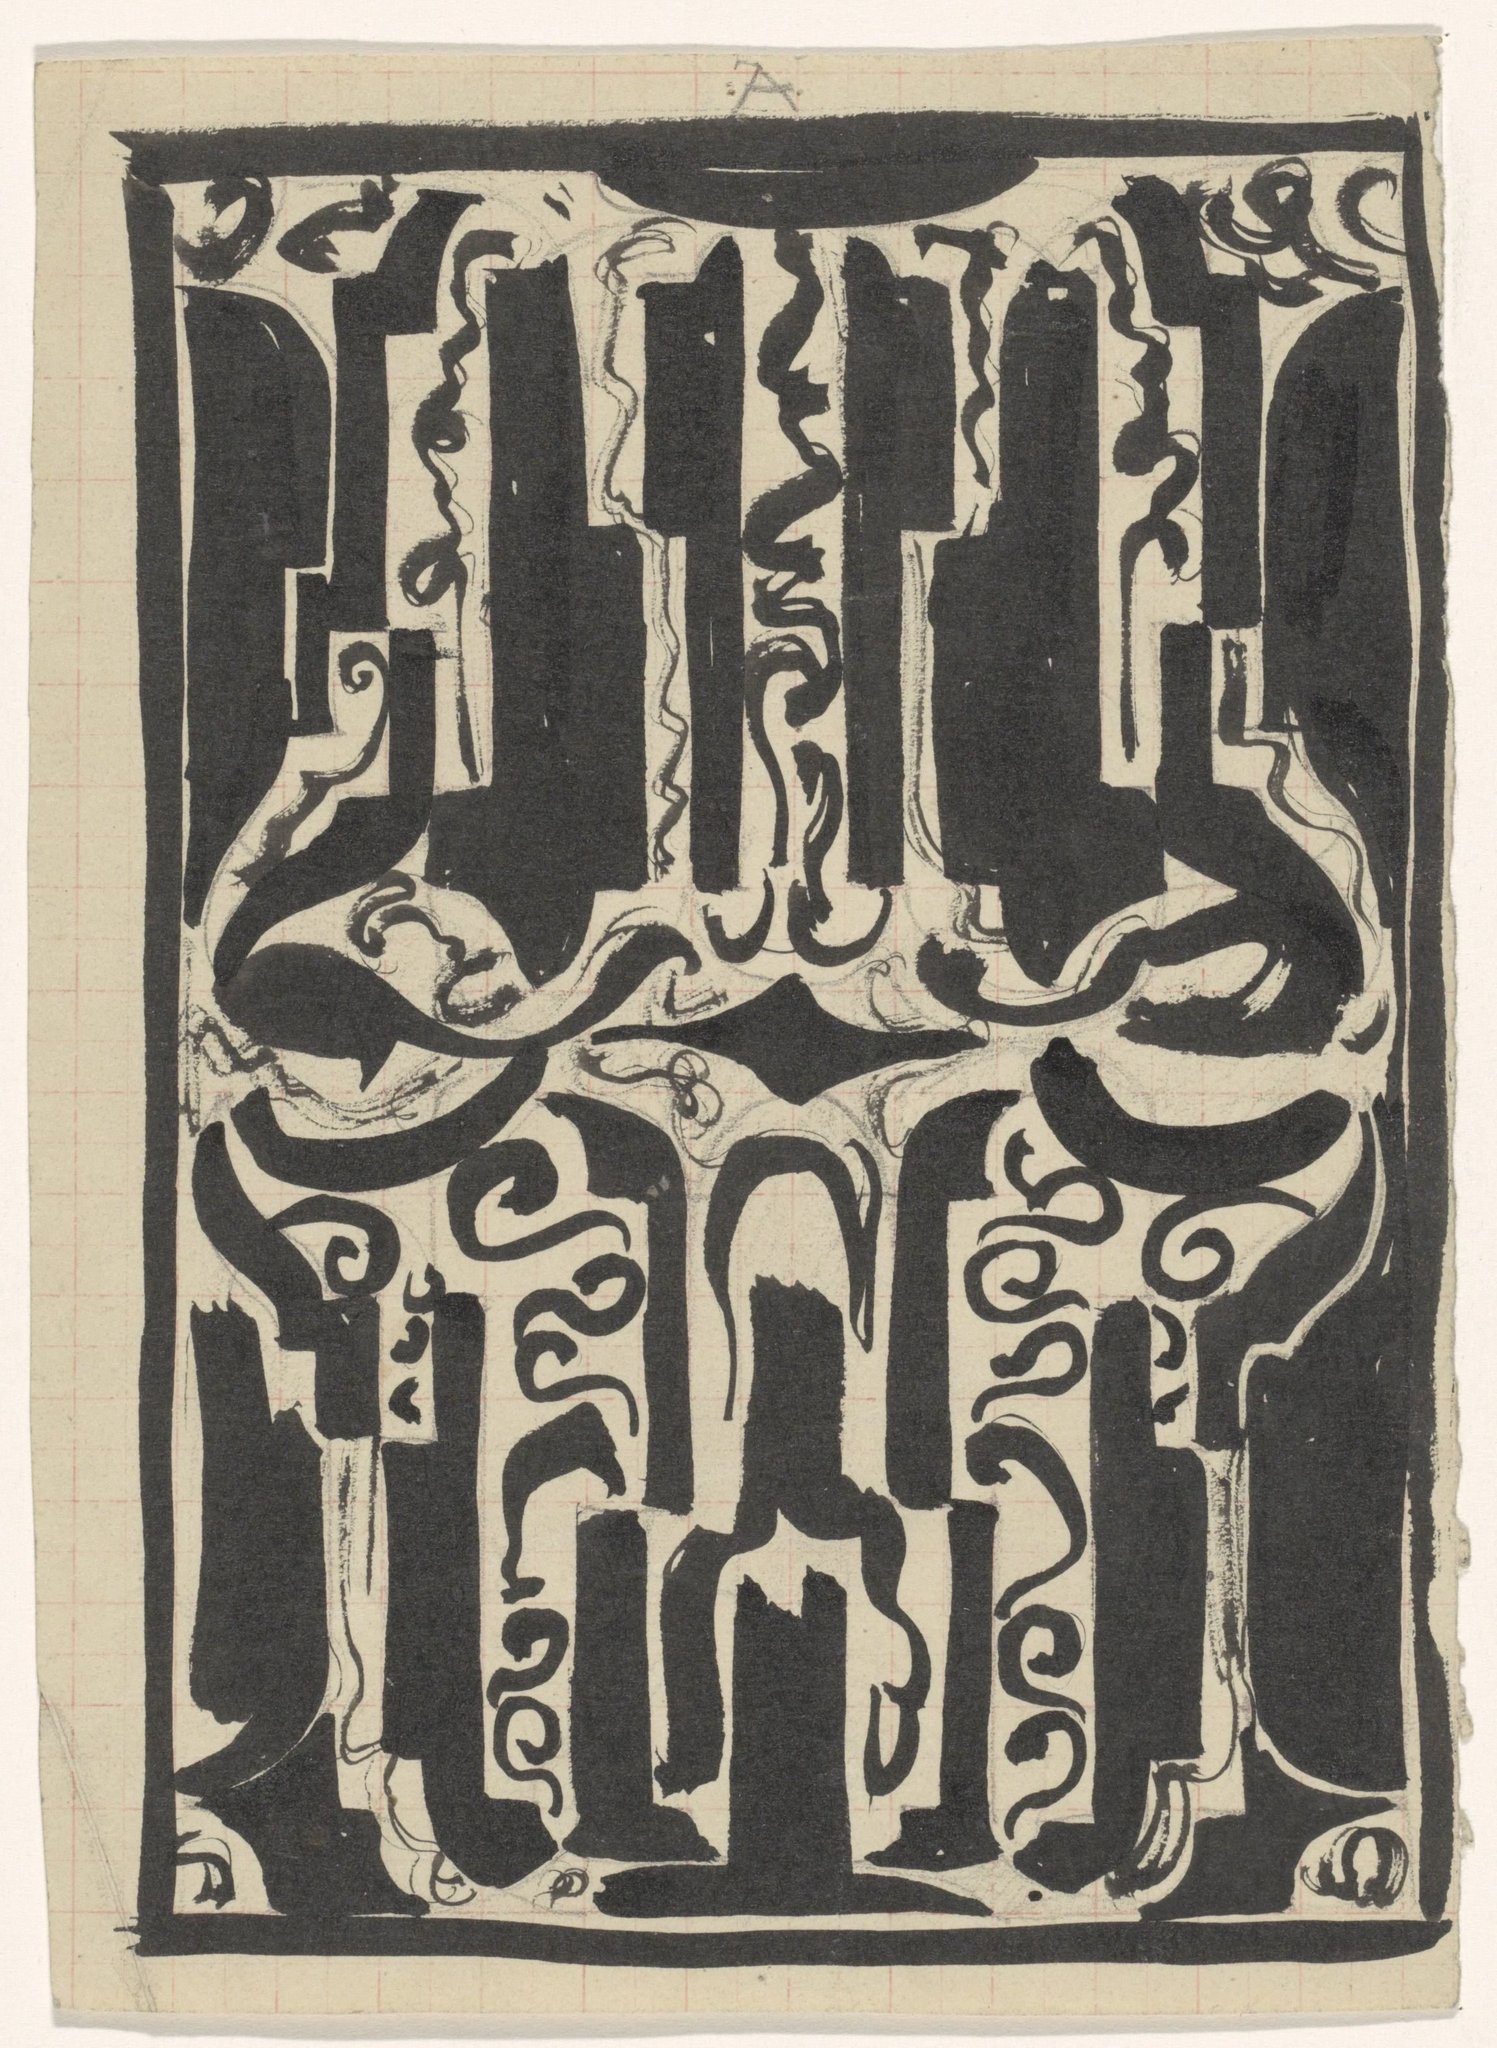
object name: drawing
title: Decoratief ontwerp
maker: carel adolph lion cachet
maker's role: draughtsman, print maker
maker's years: 1864-1945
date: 1874-1945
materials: ink, paper, pencil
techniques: brush, pen